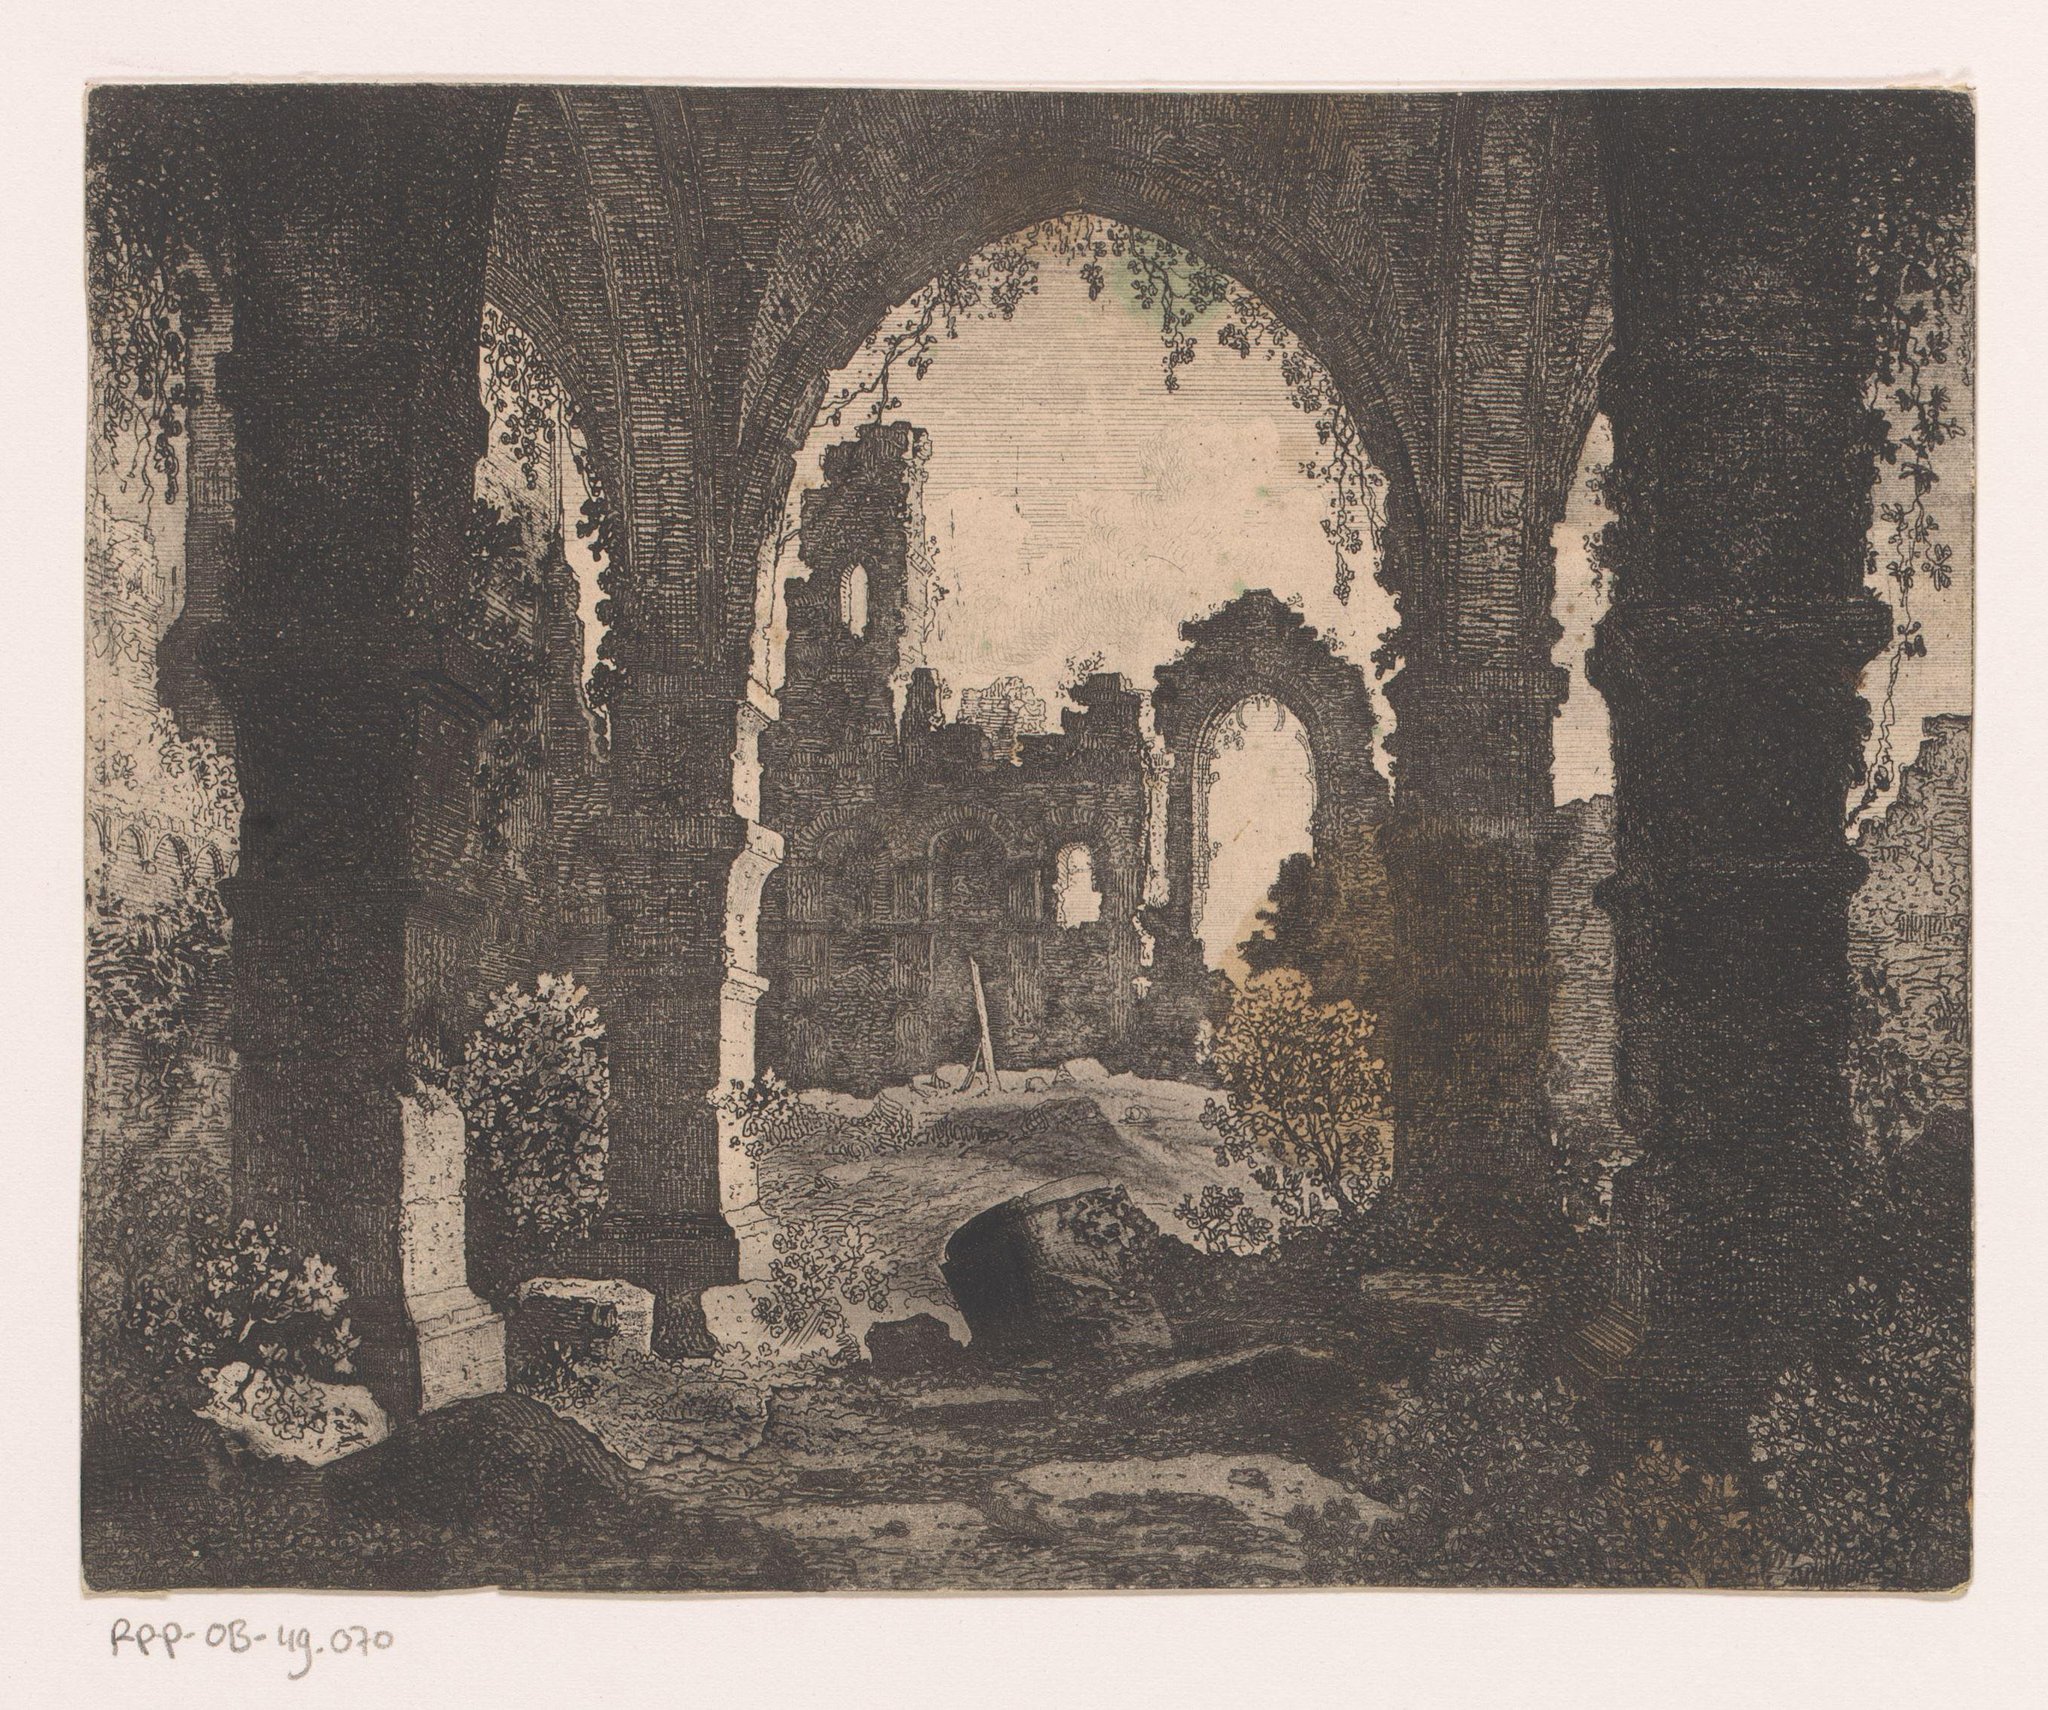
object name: print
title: Gezicht op de ruïne van kasteel Kenilworth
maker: guillaume van der hecht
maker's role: print maker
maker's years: 1817-1891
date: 1827-1879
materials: paper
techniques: etching, intaglio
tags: landscape with tower or castle, ruin of a dwelling, house, castle, etc.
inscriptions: collector's mark: Lugt 2228